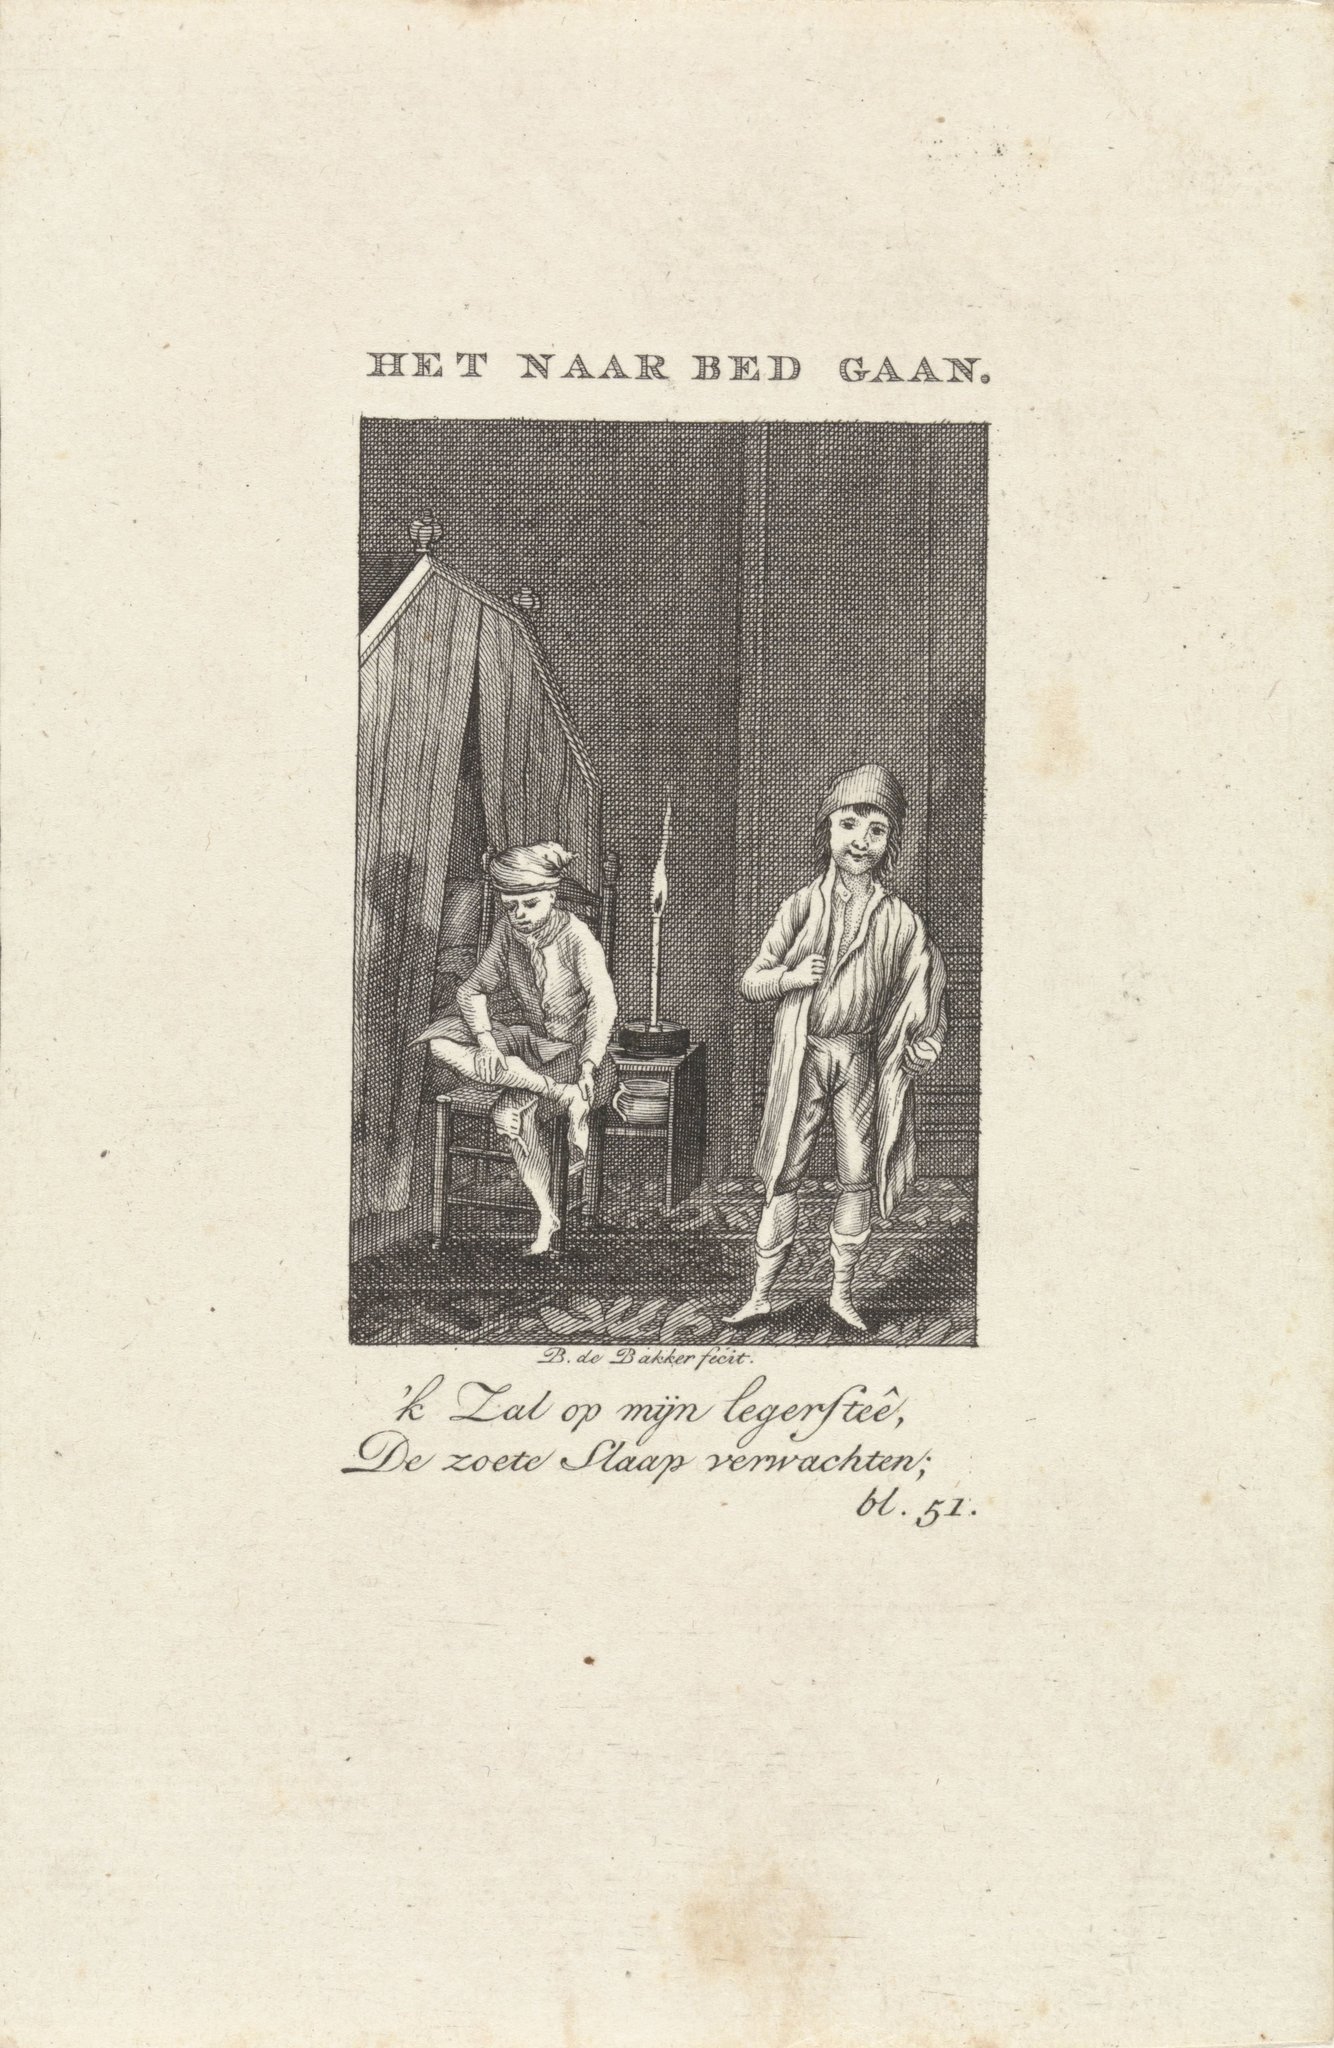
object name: print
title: Children in their Nightwear in a Bedroom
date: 1789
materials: paper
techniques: engraving, etching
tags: child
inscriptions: collector's mark: Lugt 2228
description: Prent uit: Hazeu, Johannes Cornelisz., Agt kunstplaaten behoorende tot de Kinderpligt en zinnebeelden, Willem van Vliet (uitgever), Amsterdam 1789.